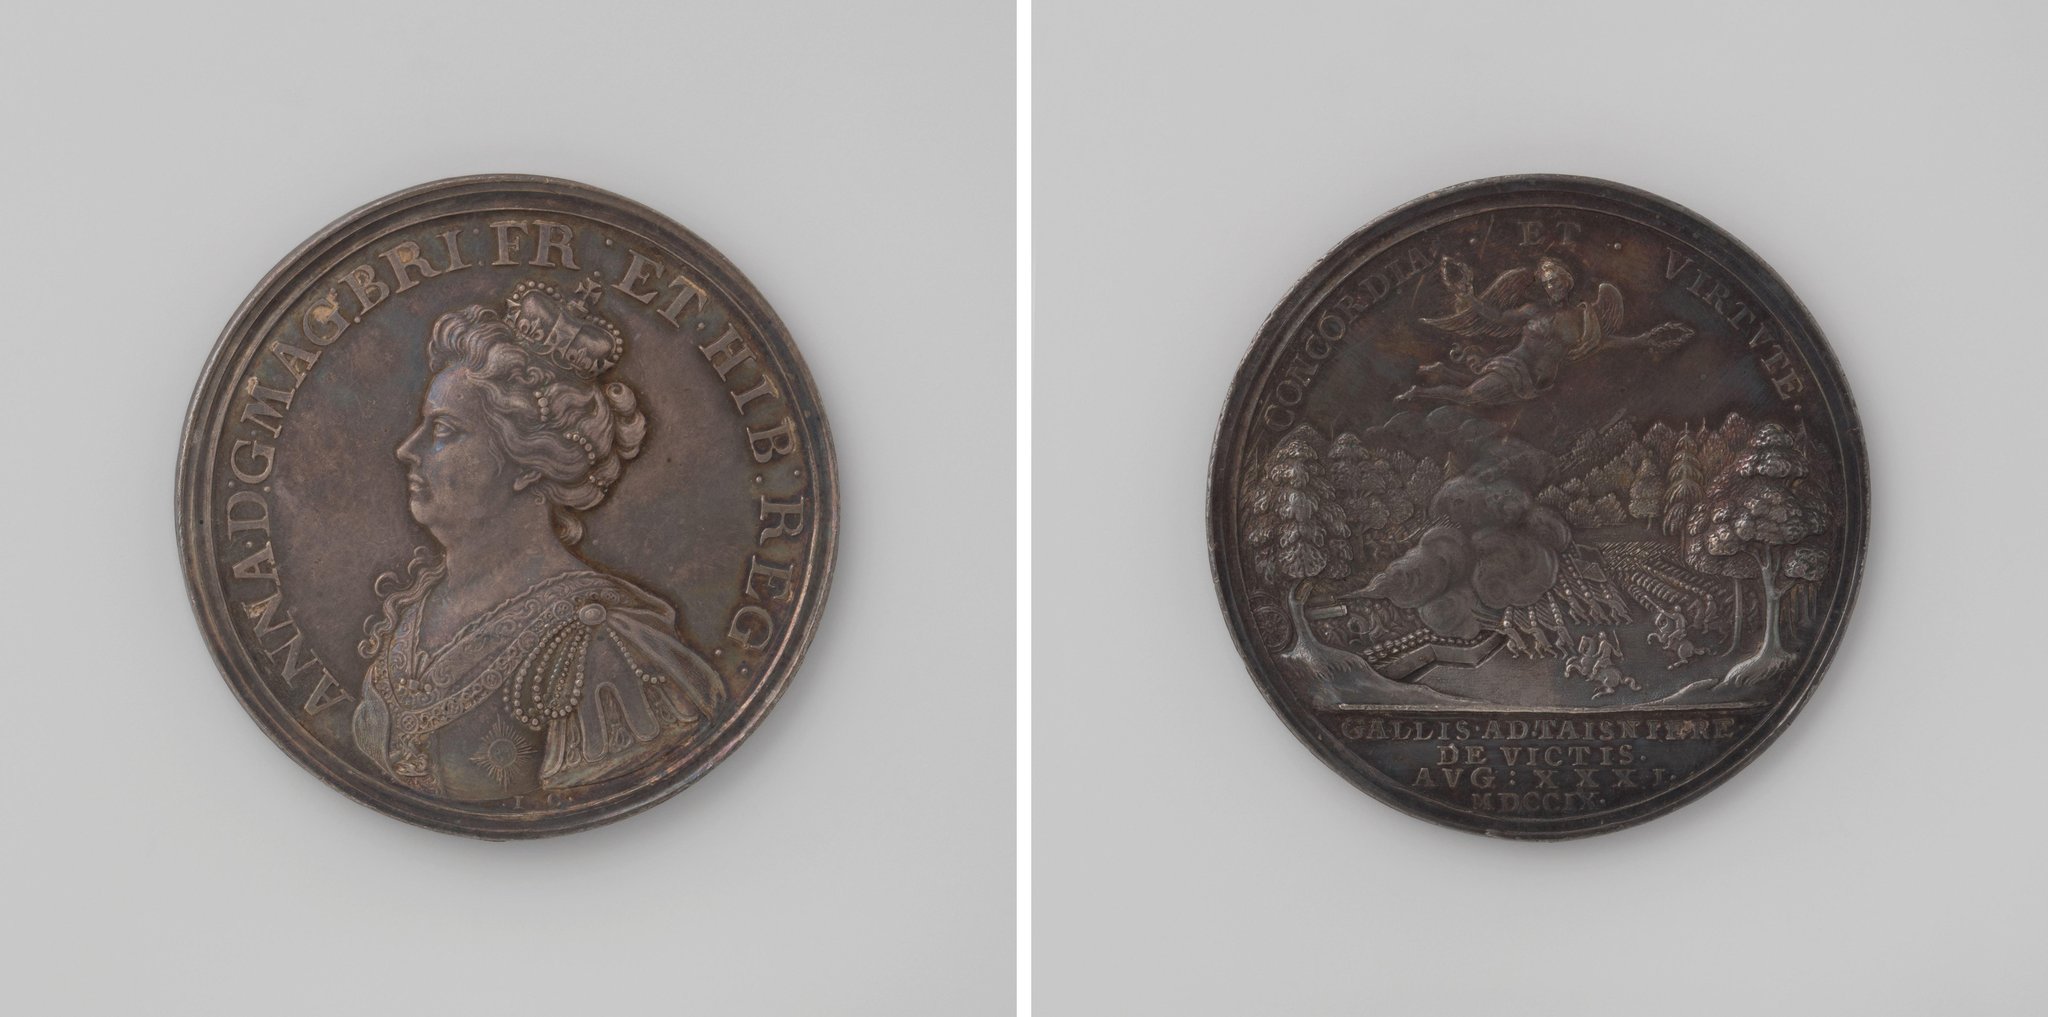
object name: history medal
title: Slag bij Malplaquet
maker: john croker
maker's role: die cutter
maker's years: 1670-1741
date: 1709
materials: silver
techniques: striking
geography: london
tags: london, anna stuart (koningin van engeland en schotland)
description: Zilveren penning. Voorzijde: borststuk vrouw met kroon binnen omschrift. Keerzijde: veldslag in bos; daarboven Overwinning met twee lauwerkransen binnen omschrift, boven opschrift